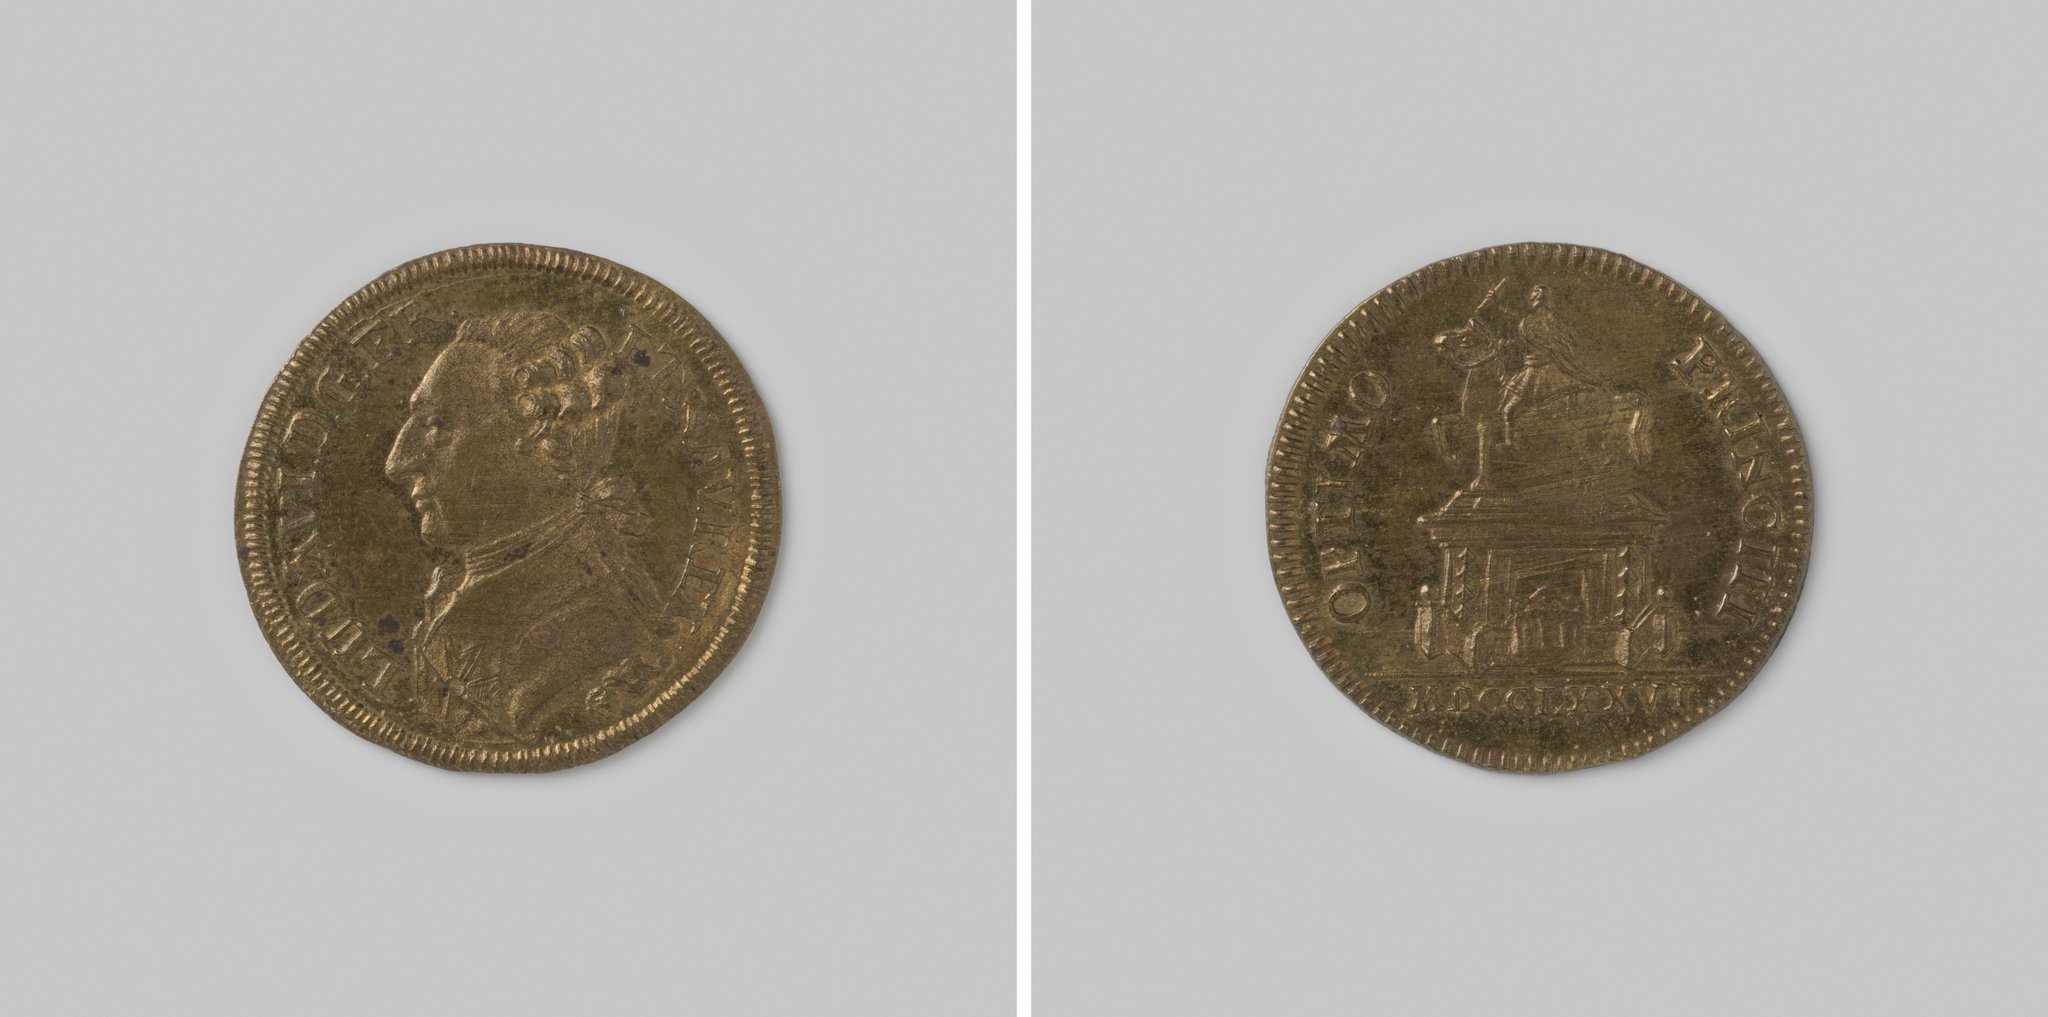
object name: jeton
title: Rekenpenning uit Neurenberg met koning Lodewijk XVI van Frankrijk 1776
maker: johann christian reich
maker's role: medailleur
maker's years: 1740-1814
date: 1776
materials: brass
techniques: striking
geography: nuremberg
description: Messing penning, op de voorzijde het borstbeeld van Lodewijk XVI naar links met omschrift, op de keerzijde een ruiterstandbeeld op sokkel met omschrift en afsnedetekst.